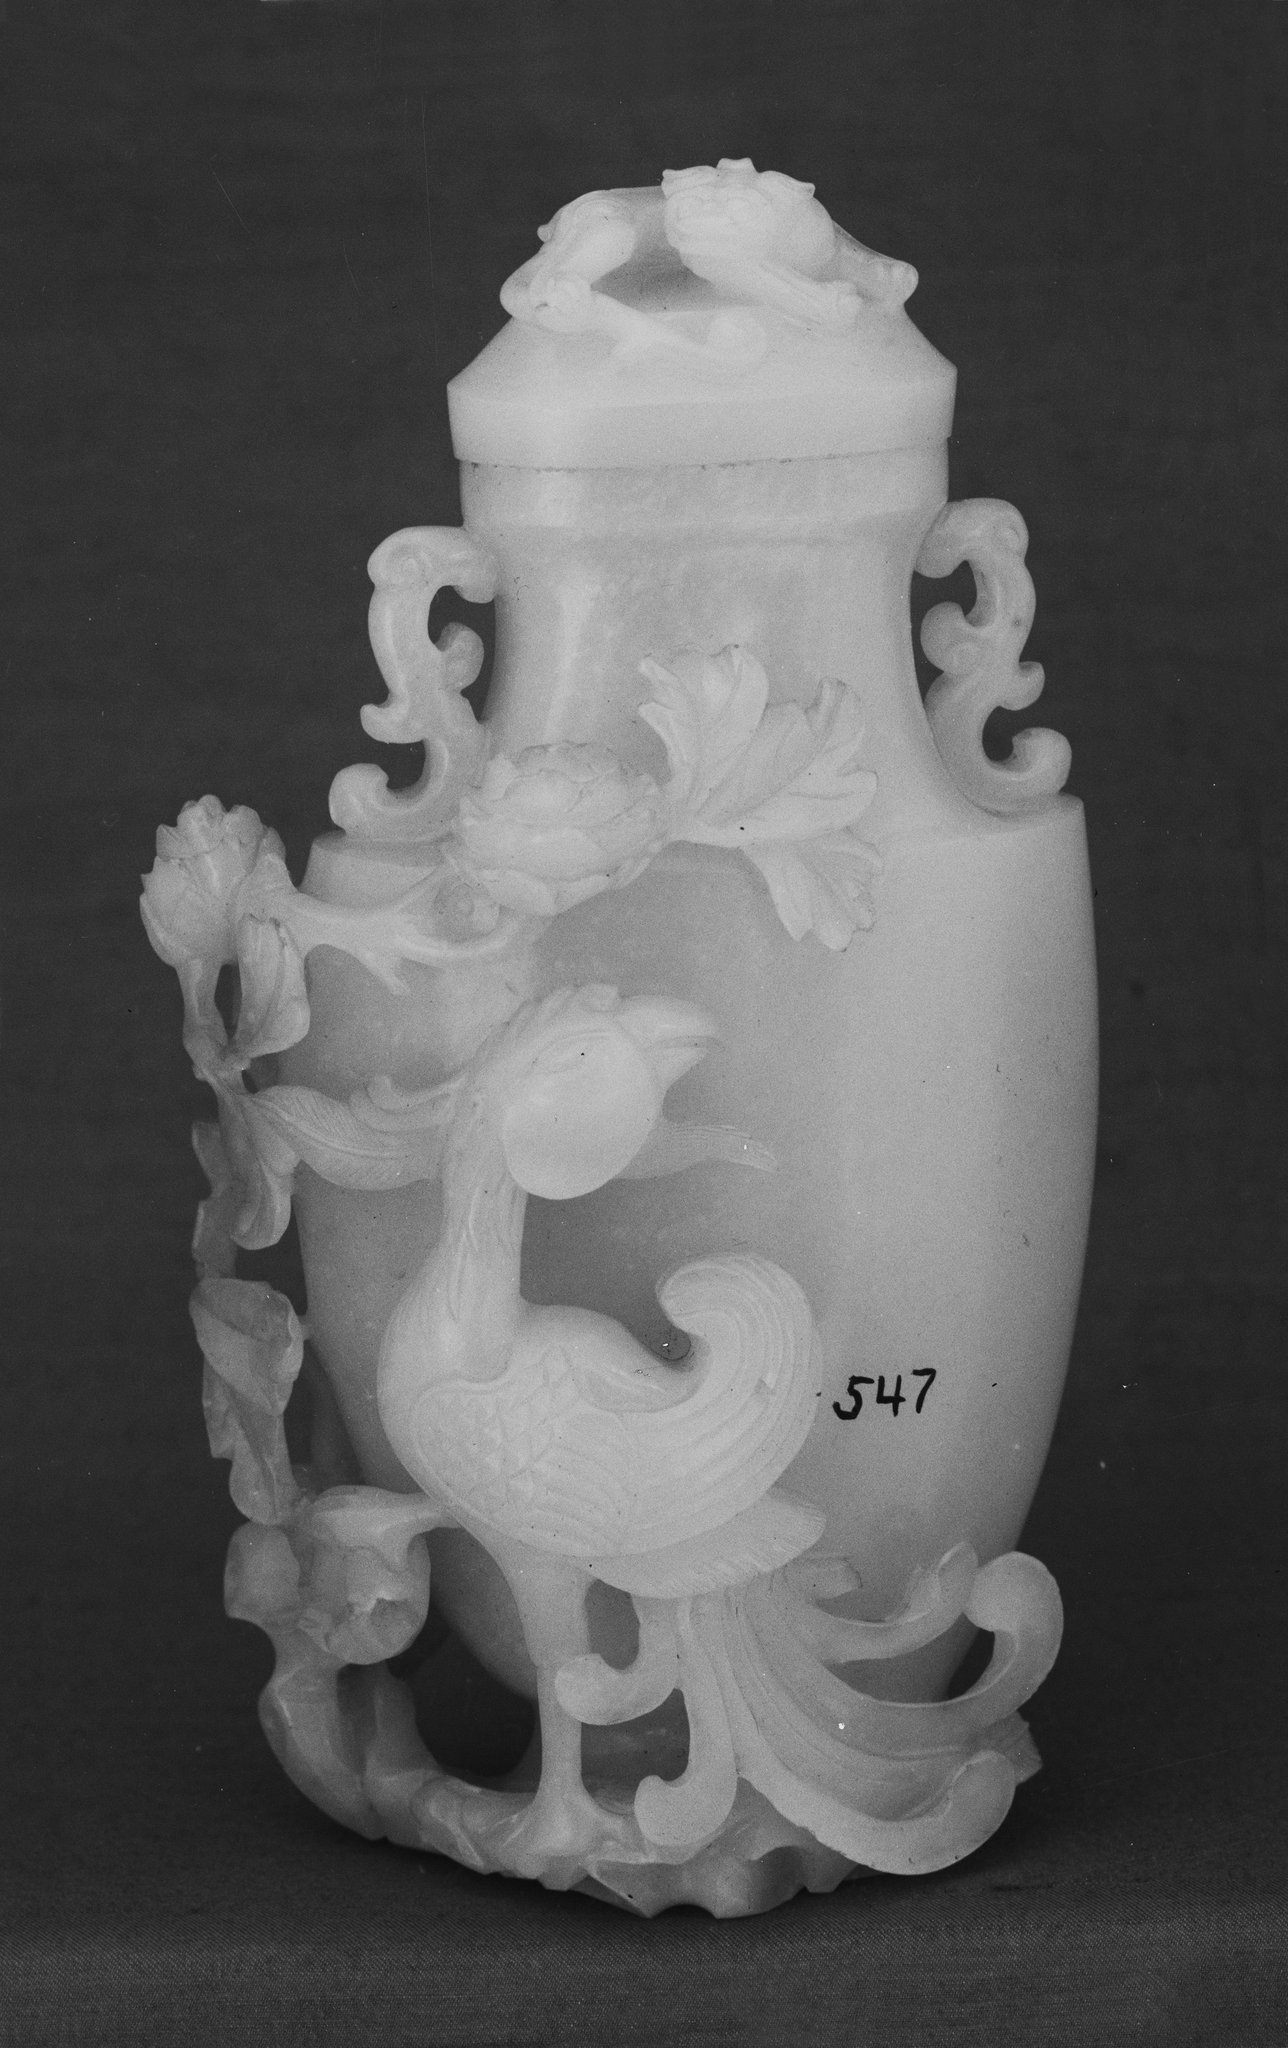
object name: vase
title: Covered vase with phoenix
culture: chinese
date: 1701-1800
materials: jade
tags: mythical creatures,flowers